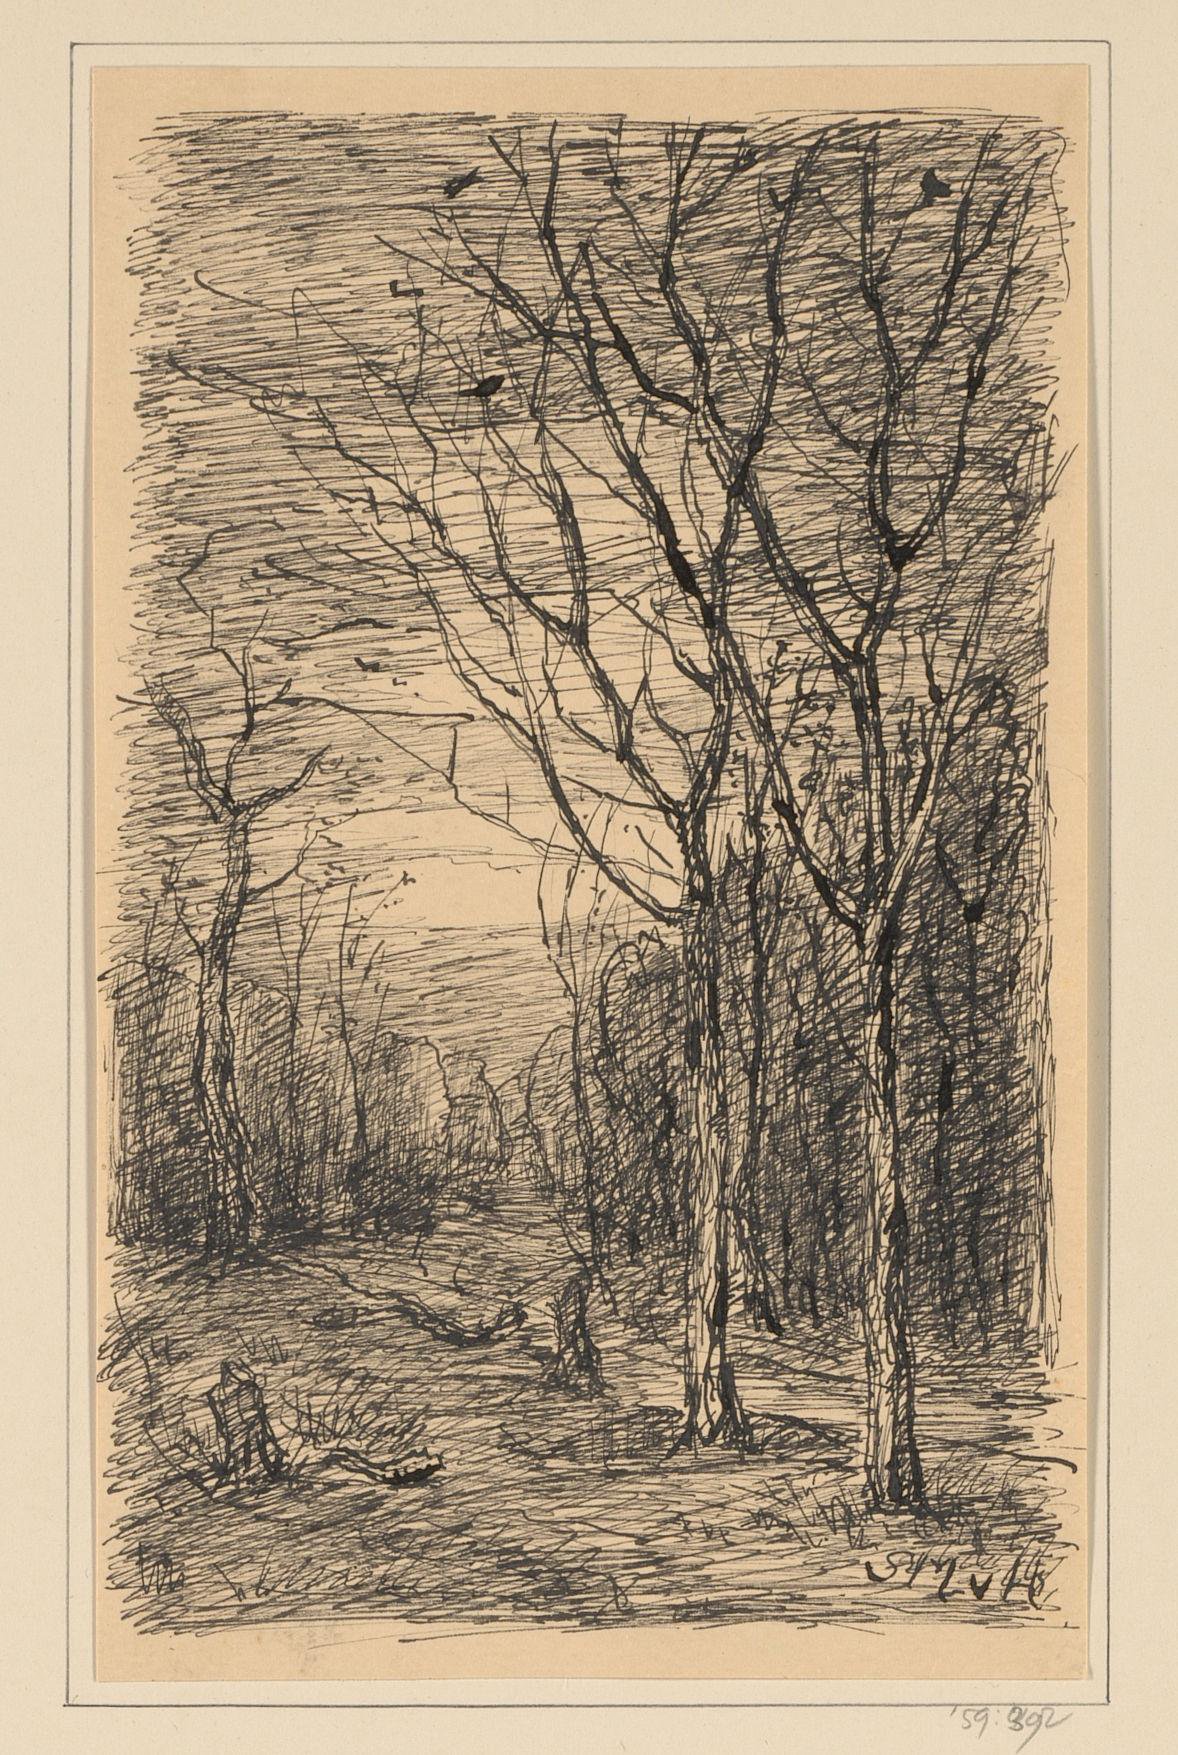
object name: drawing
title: Boslandschap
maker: sientje mesdag-van houten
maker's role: draughtsman, painter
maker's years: 1834-1909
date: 1856-1909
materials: ink, paper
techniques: pen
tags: forest, wood